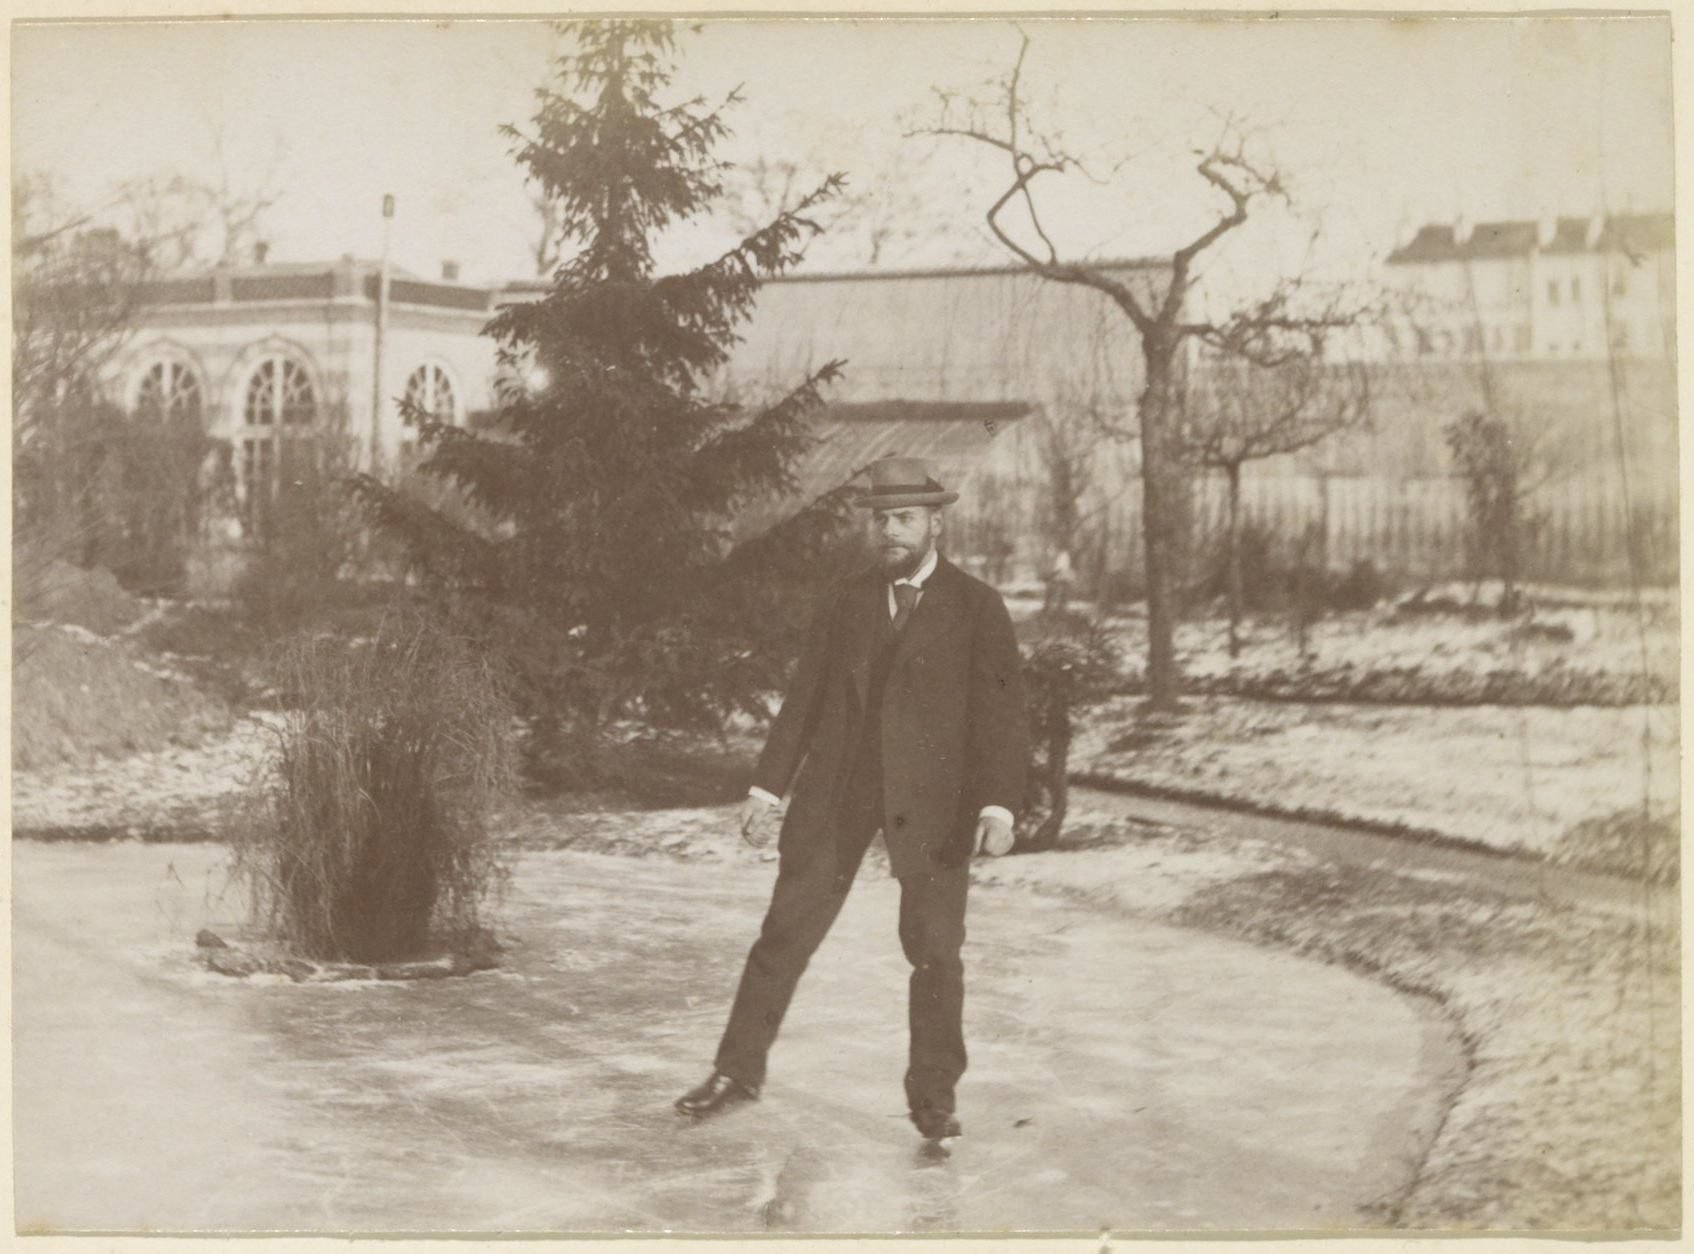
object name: photograph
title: Man schaatsend op een vijver bij een oranjerie in Frankrijk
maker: Anonymous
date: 1900-1910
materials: paper, photographic support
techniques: albumen print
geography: france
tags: adult man, head-gear: hat, skates (winter sports), greenhouse, orangery, trees: fir, france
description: Onderdeel van Fotoalbum van een Franse amateurfotograaf met opnames van een familie, distilleerderij Delizy & Doistau Fils, het leger en bezienswaardigheden in Frankrijk.